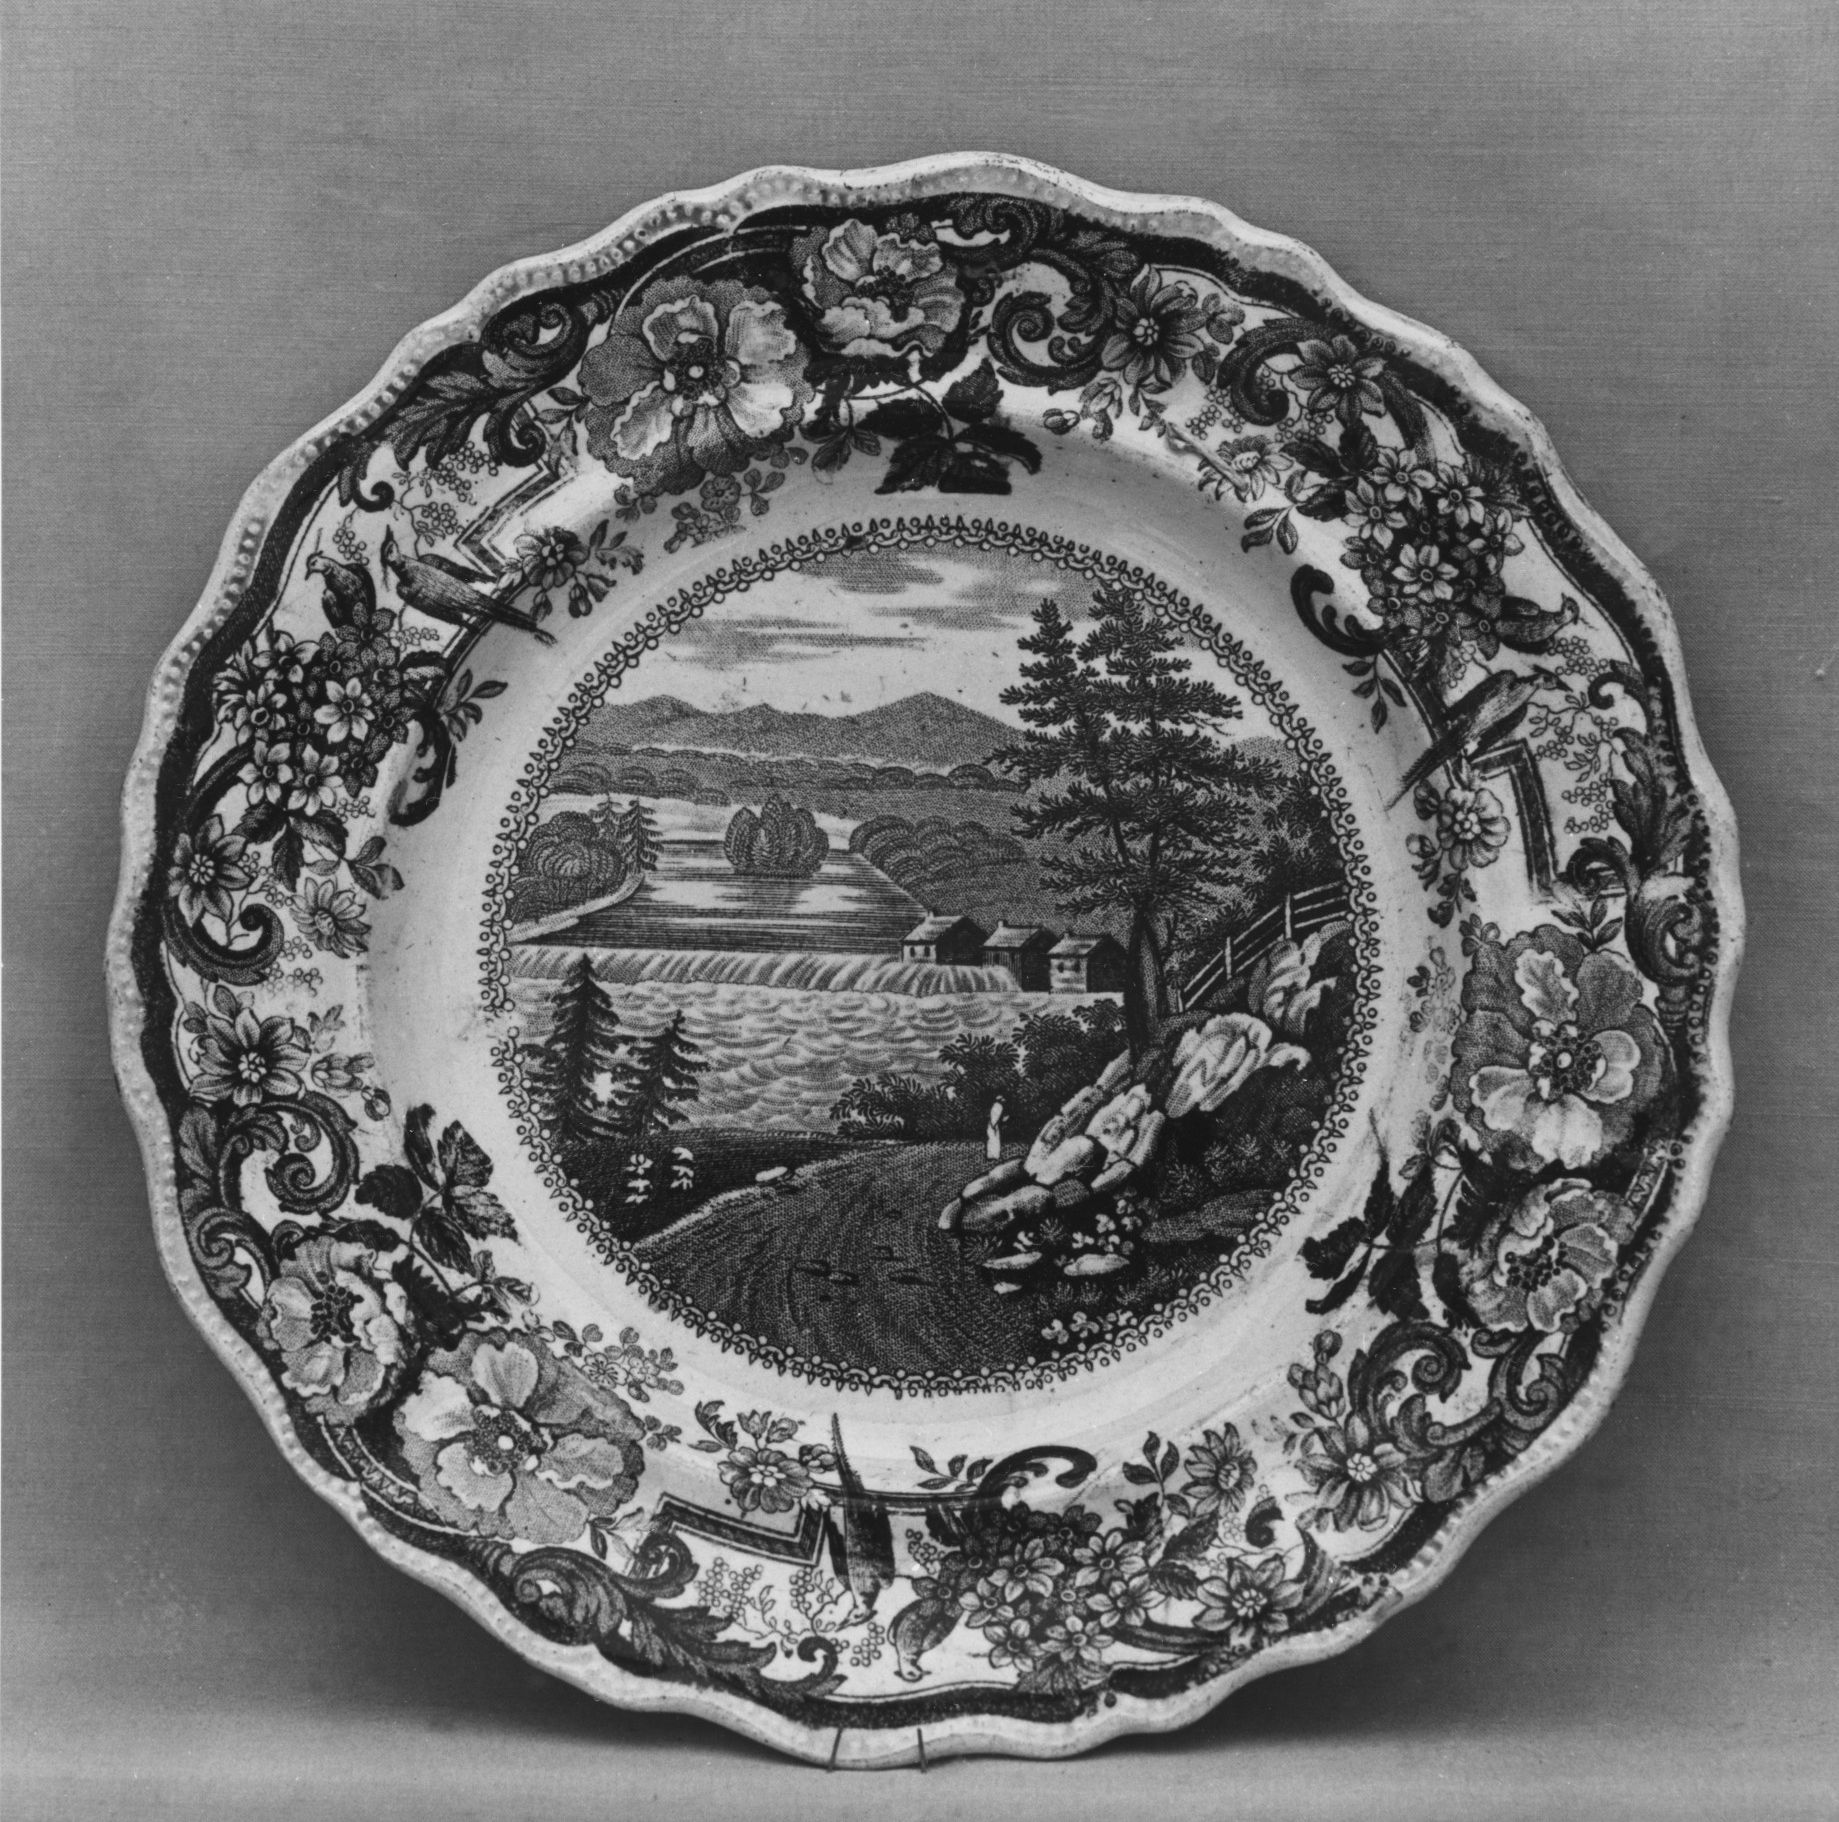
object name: plate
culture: british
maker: james and ralph clews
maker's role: maker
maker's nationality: british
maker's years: 1813-1836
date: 1822-1834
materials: earthenware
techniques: transfer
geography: england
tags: flowers,landscapes